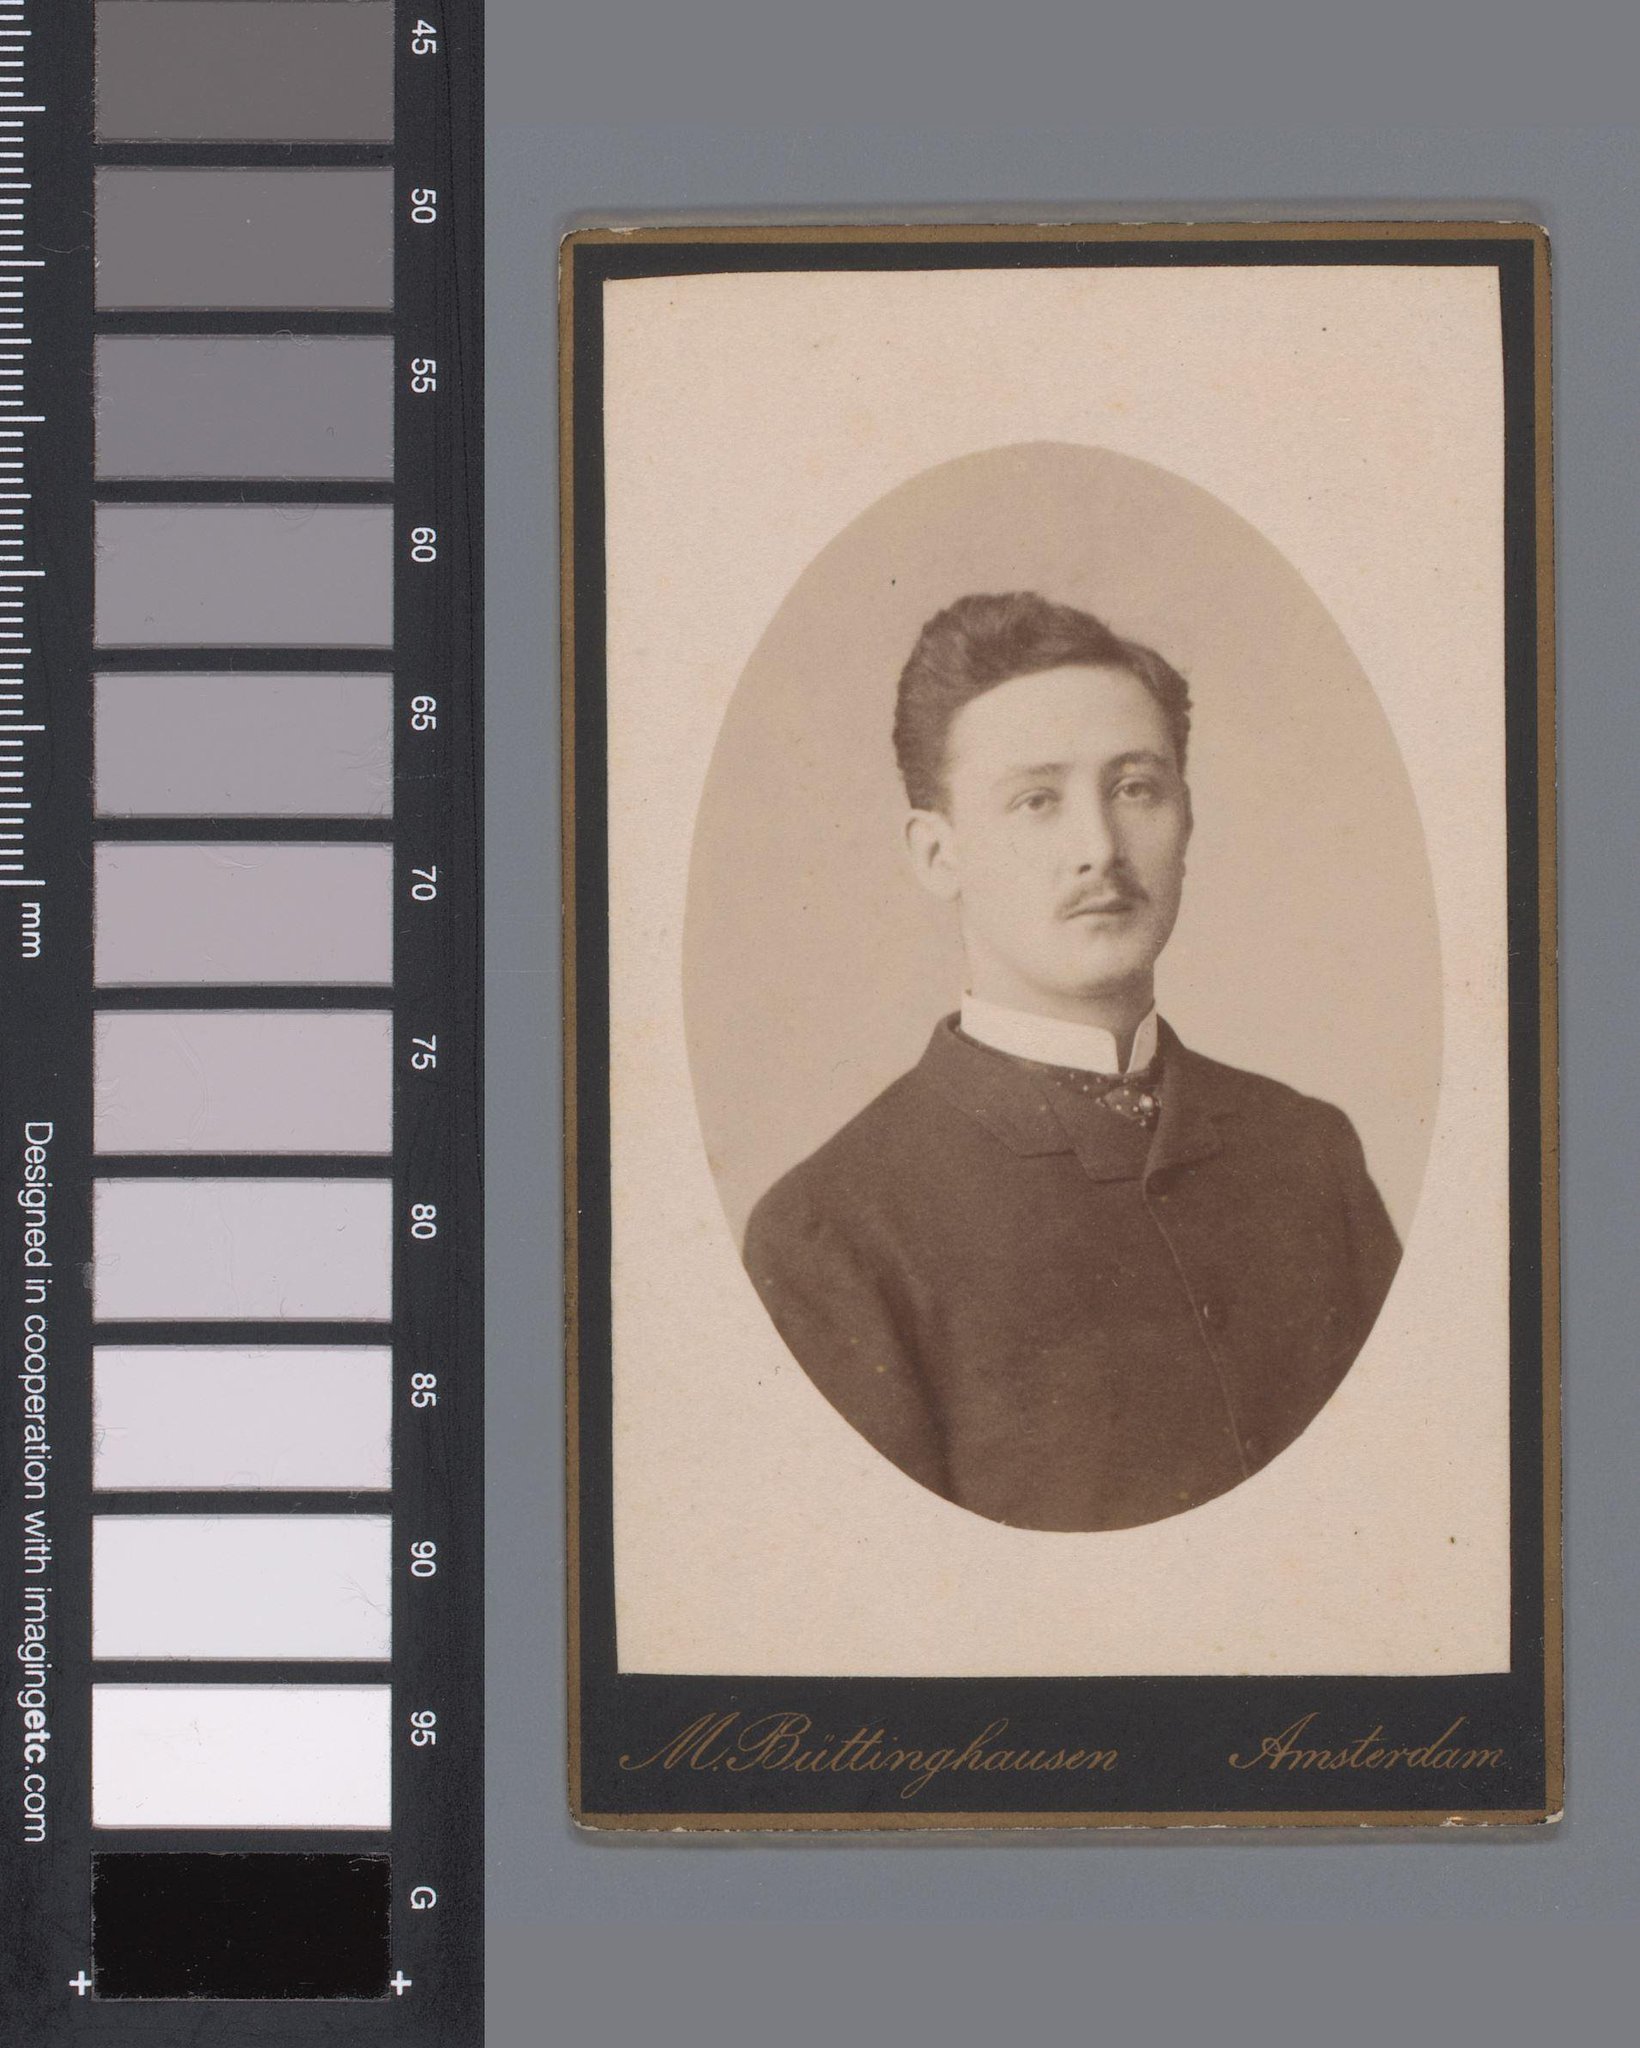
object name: photograph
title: Portret van een onbekende man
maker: max büttinghausen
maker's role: fotograaf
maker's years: 1847-1906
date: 1873-1888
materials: cardboard, paper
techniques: albumen print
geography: amsterdam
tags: adult man, anonymous historical person portrayed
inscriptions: address: ‘Amsterdam/ Singel bij het Koningsplein No 512.’, inscription: ‘SPECIALITEIT IN VERGROOTINGEN.’